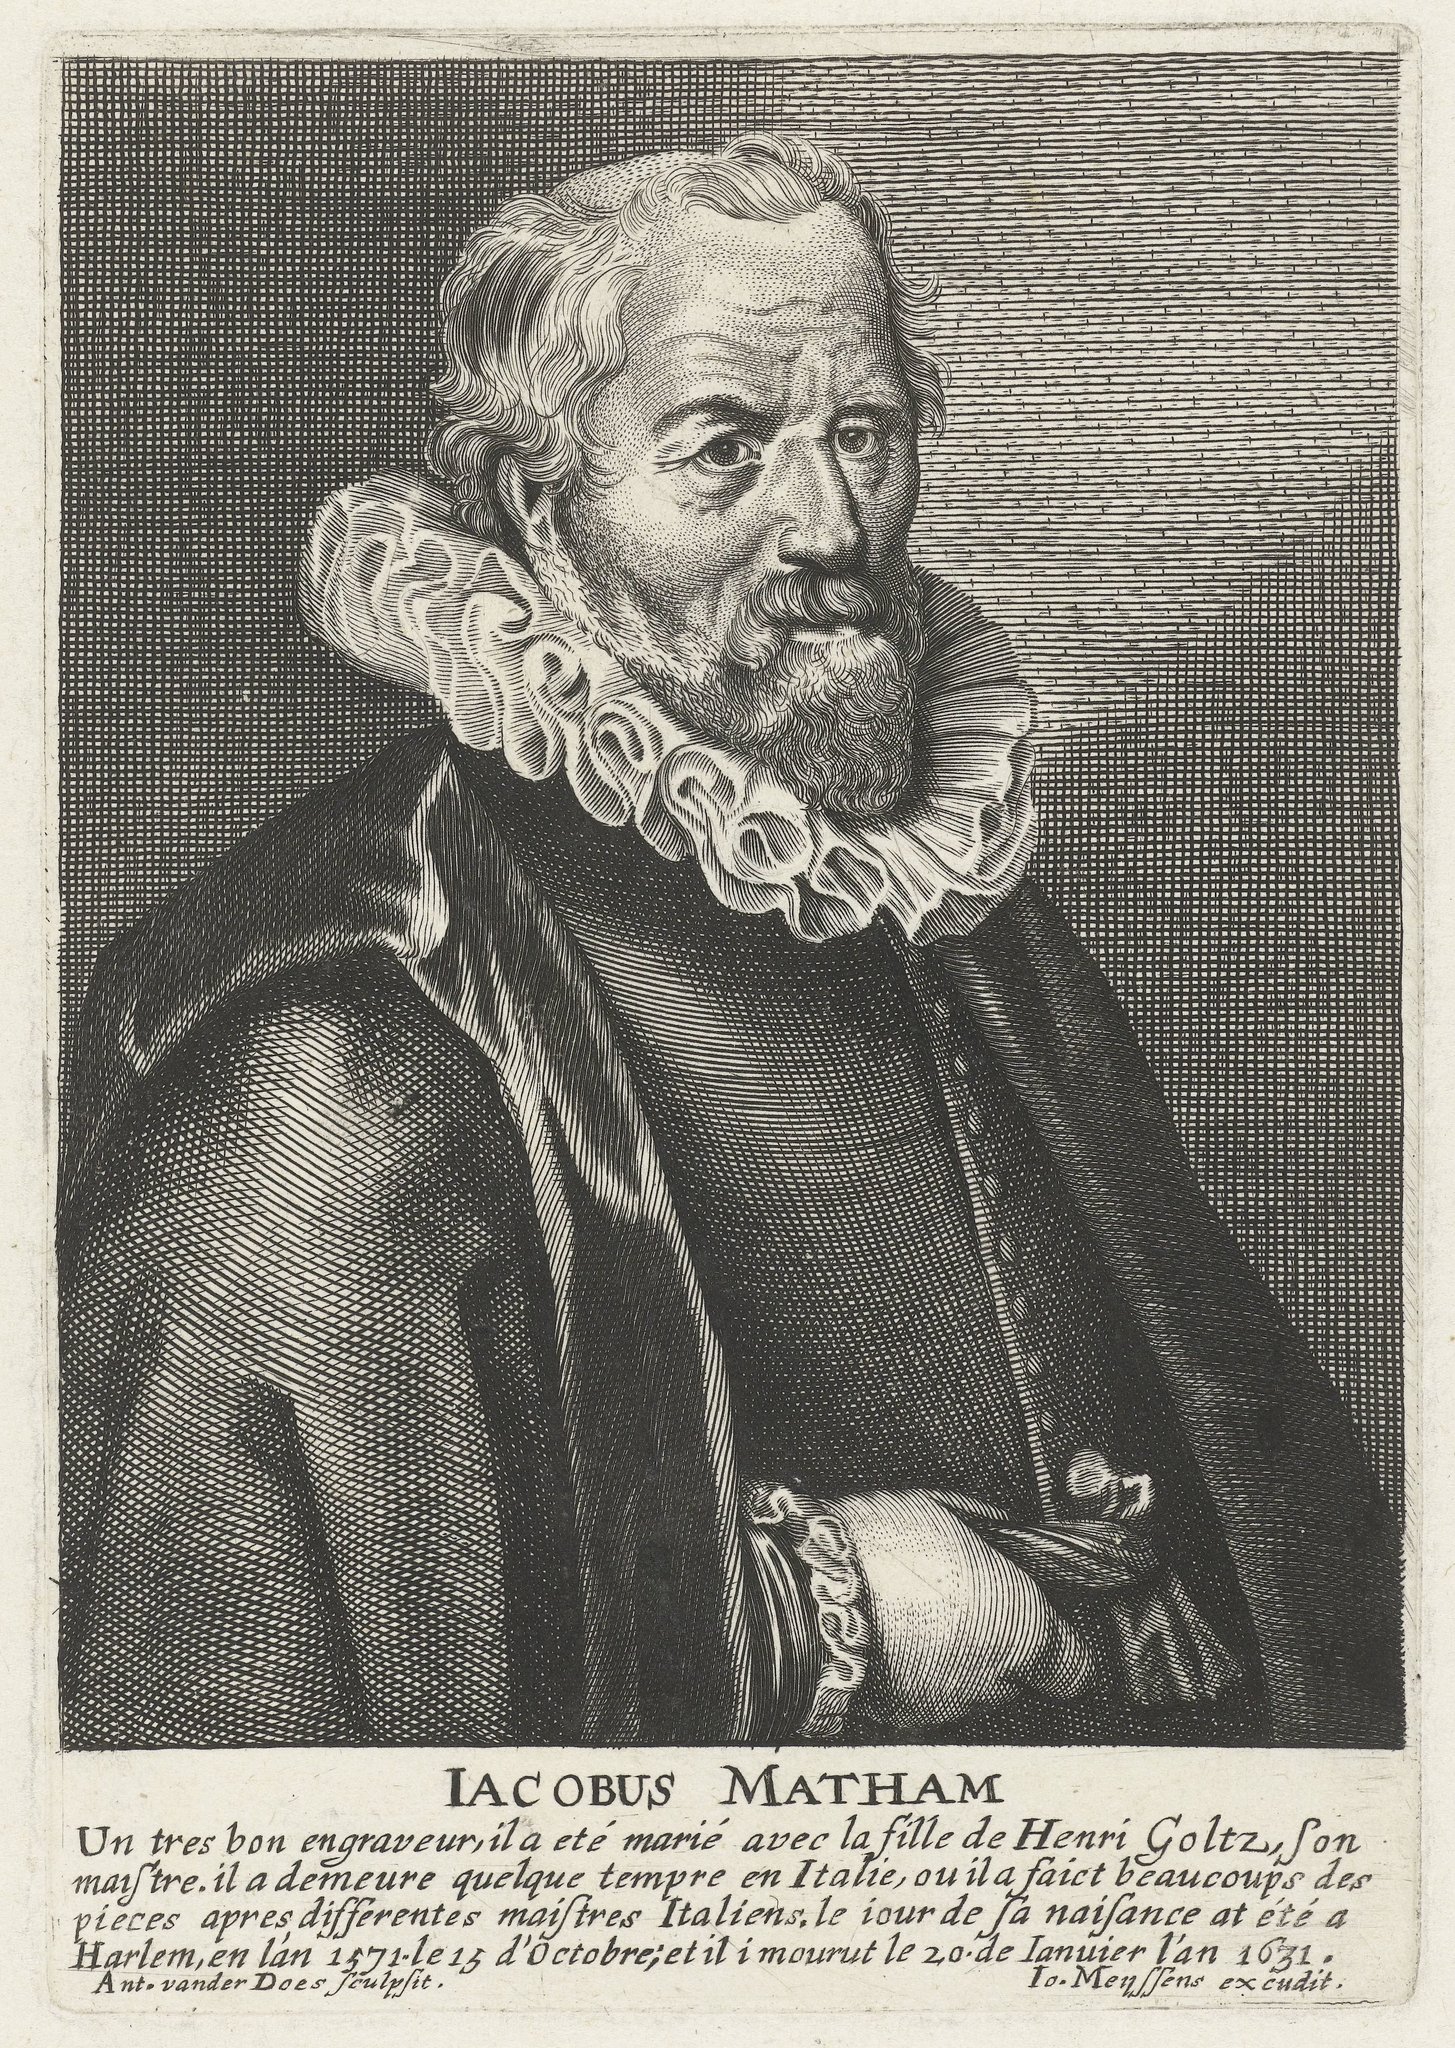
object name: print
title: Portret van Jacob Matham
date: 1631-1680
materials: paper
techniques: engraving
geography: southern netherlands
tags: haarlem, print maker, draughtsman, jacob matham, portrait, self-portrait of painter, neck-gear: collar (+ men's clothes)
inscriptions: collector's mark: Lugt 2228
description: Portret van Jacob Matham, staand ten halven lijve met plooikraag en mantel. In ondermarge zes regels Franse tekst.